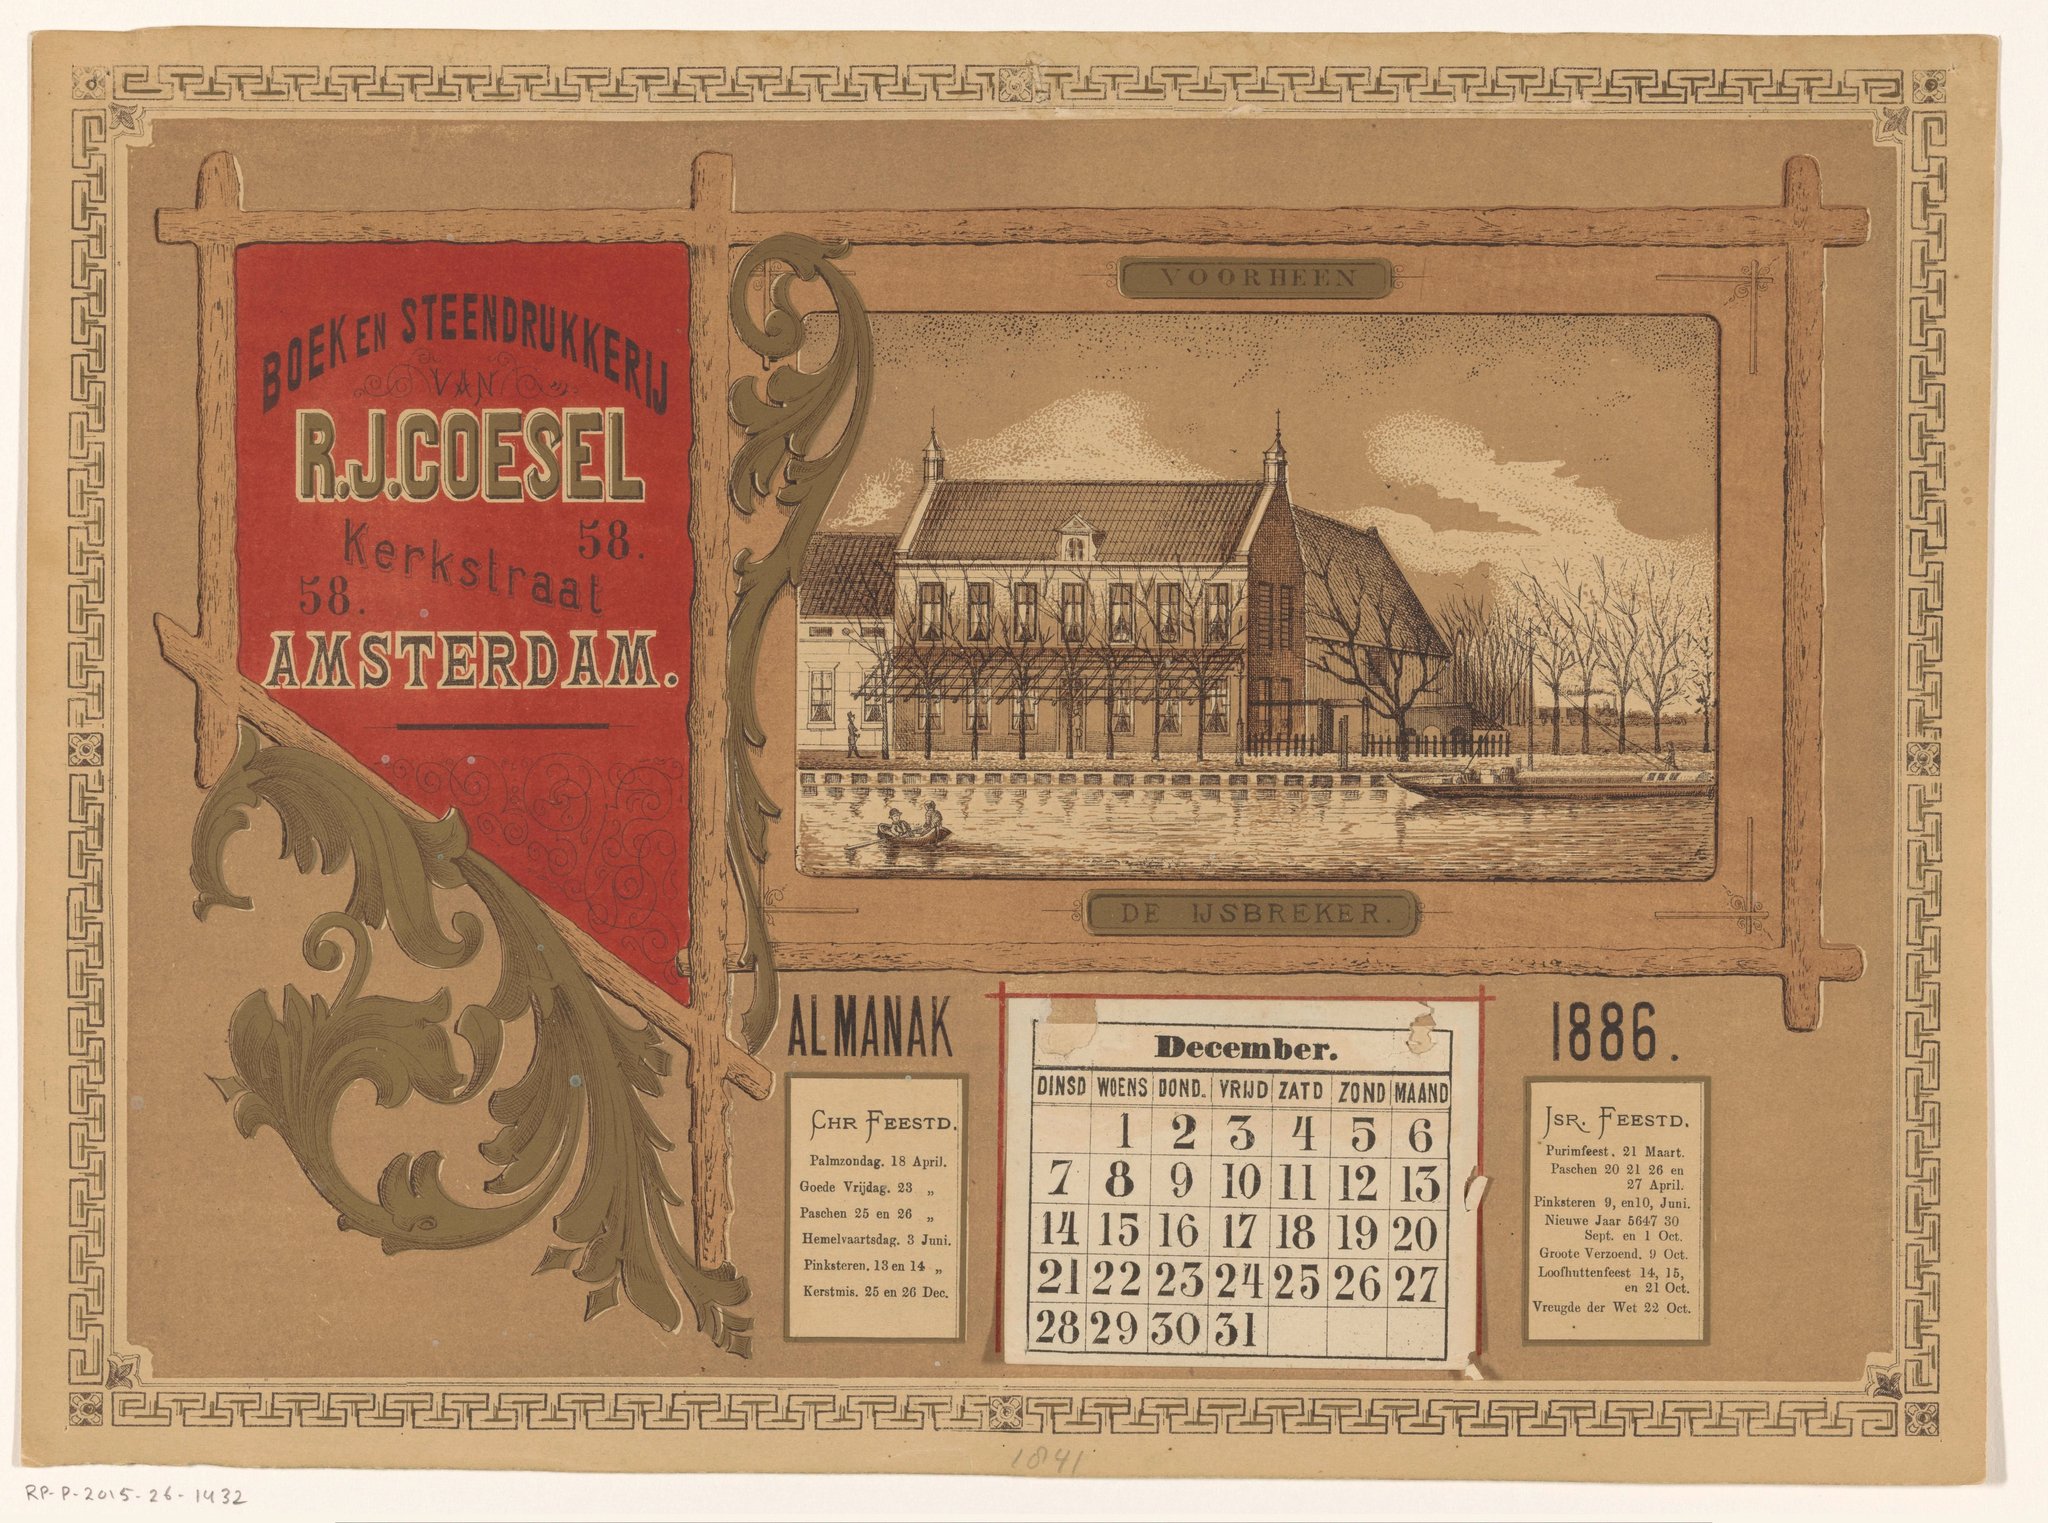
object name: print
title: Kalender voor 1886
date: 1885-1886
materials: paper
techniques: chromolithography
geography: amsterdam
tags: calendar, almanac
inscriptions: collector's mark: Lugt 4779, collector's mark: Lugt 4780, collector's mark: Lugt 2228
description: Ornamentele omlijsting met een gezicht op een gebouw aan het water genaamd 'De IJsbreker'. Onder een scheurkalender waarvan alleen het laatste blad bewaard gebleven is. Aan weerszijden een overzicht van de Christelijke en Joodse feestdagen.